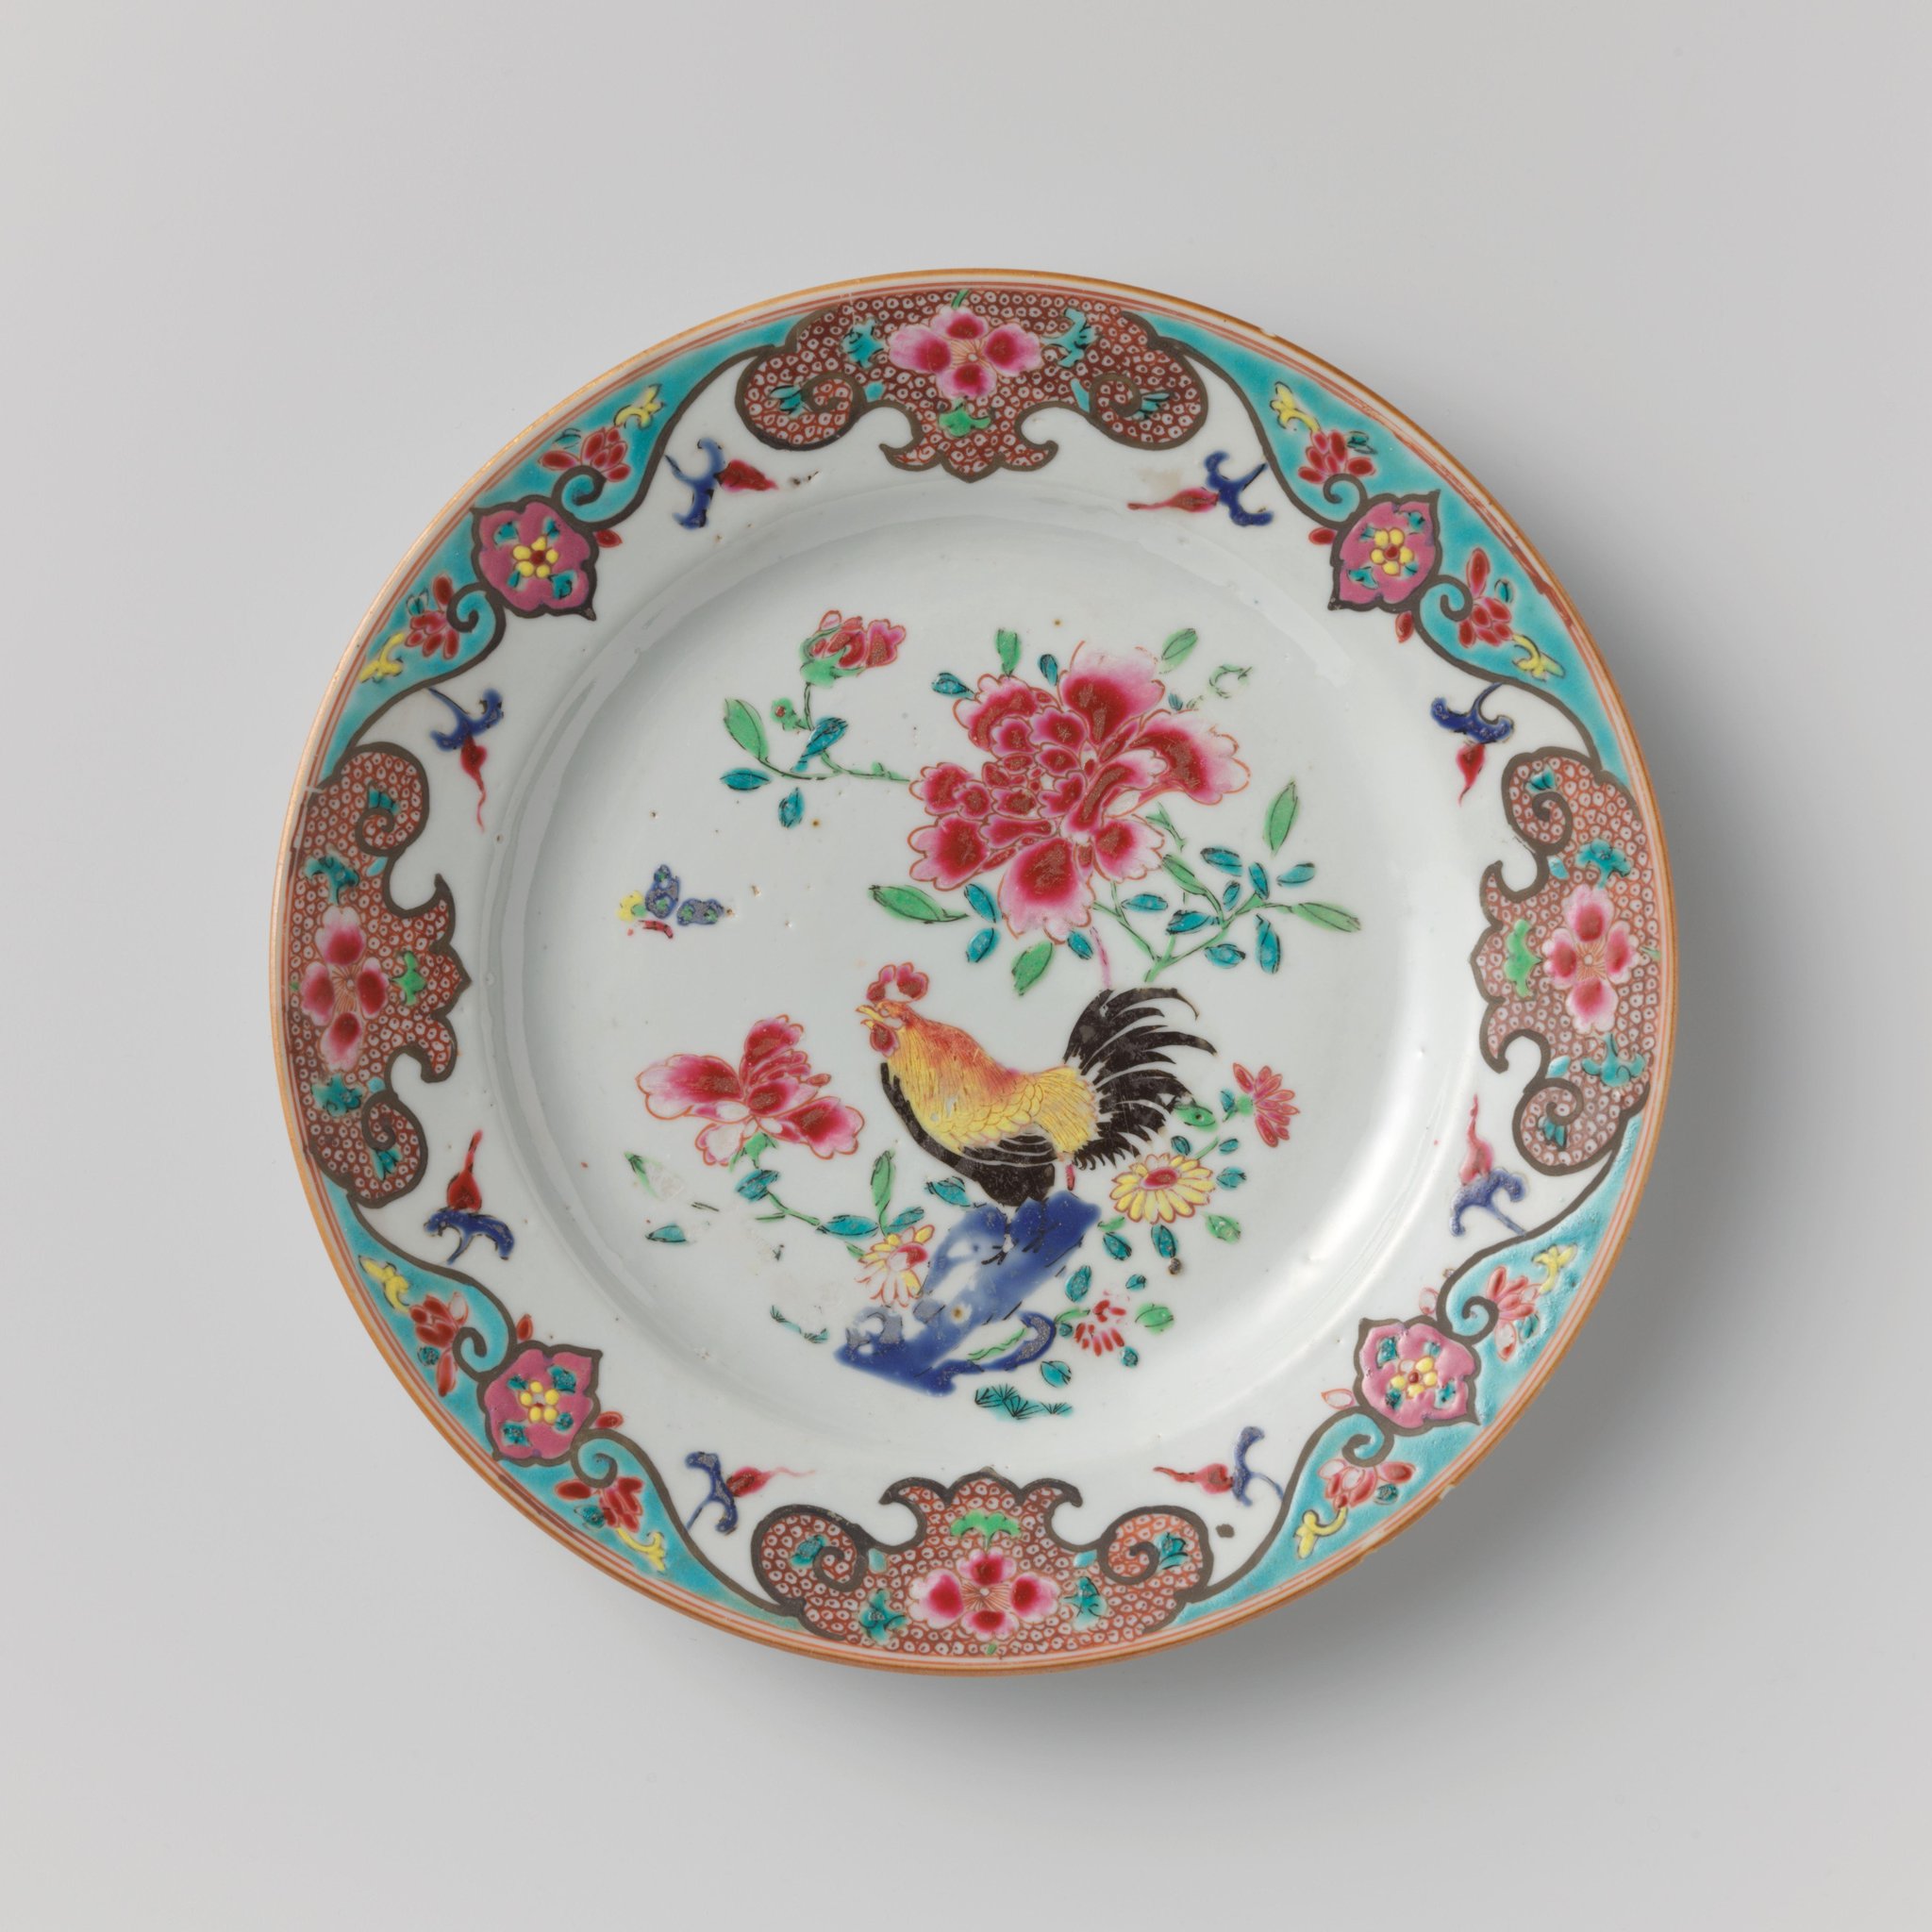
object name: plate dish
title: Plate with a cock on a rock near flowering plants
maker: Anonymous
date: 1800-1899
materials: glaze, paint, porcelain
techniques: firing, turning, vitrification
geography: china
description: Bord van porselein, beschilderd op het glazuur in blauw, rood, roze, groen, geel en zwart. Op het plat een haan op een rots bij bloeiende planten (pioen, aster) en een vlinder; op de rand een decoratieve band met krulwerk, servetwerk, bloemtakken en gestileerde lotusranken. Famille rose.